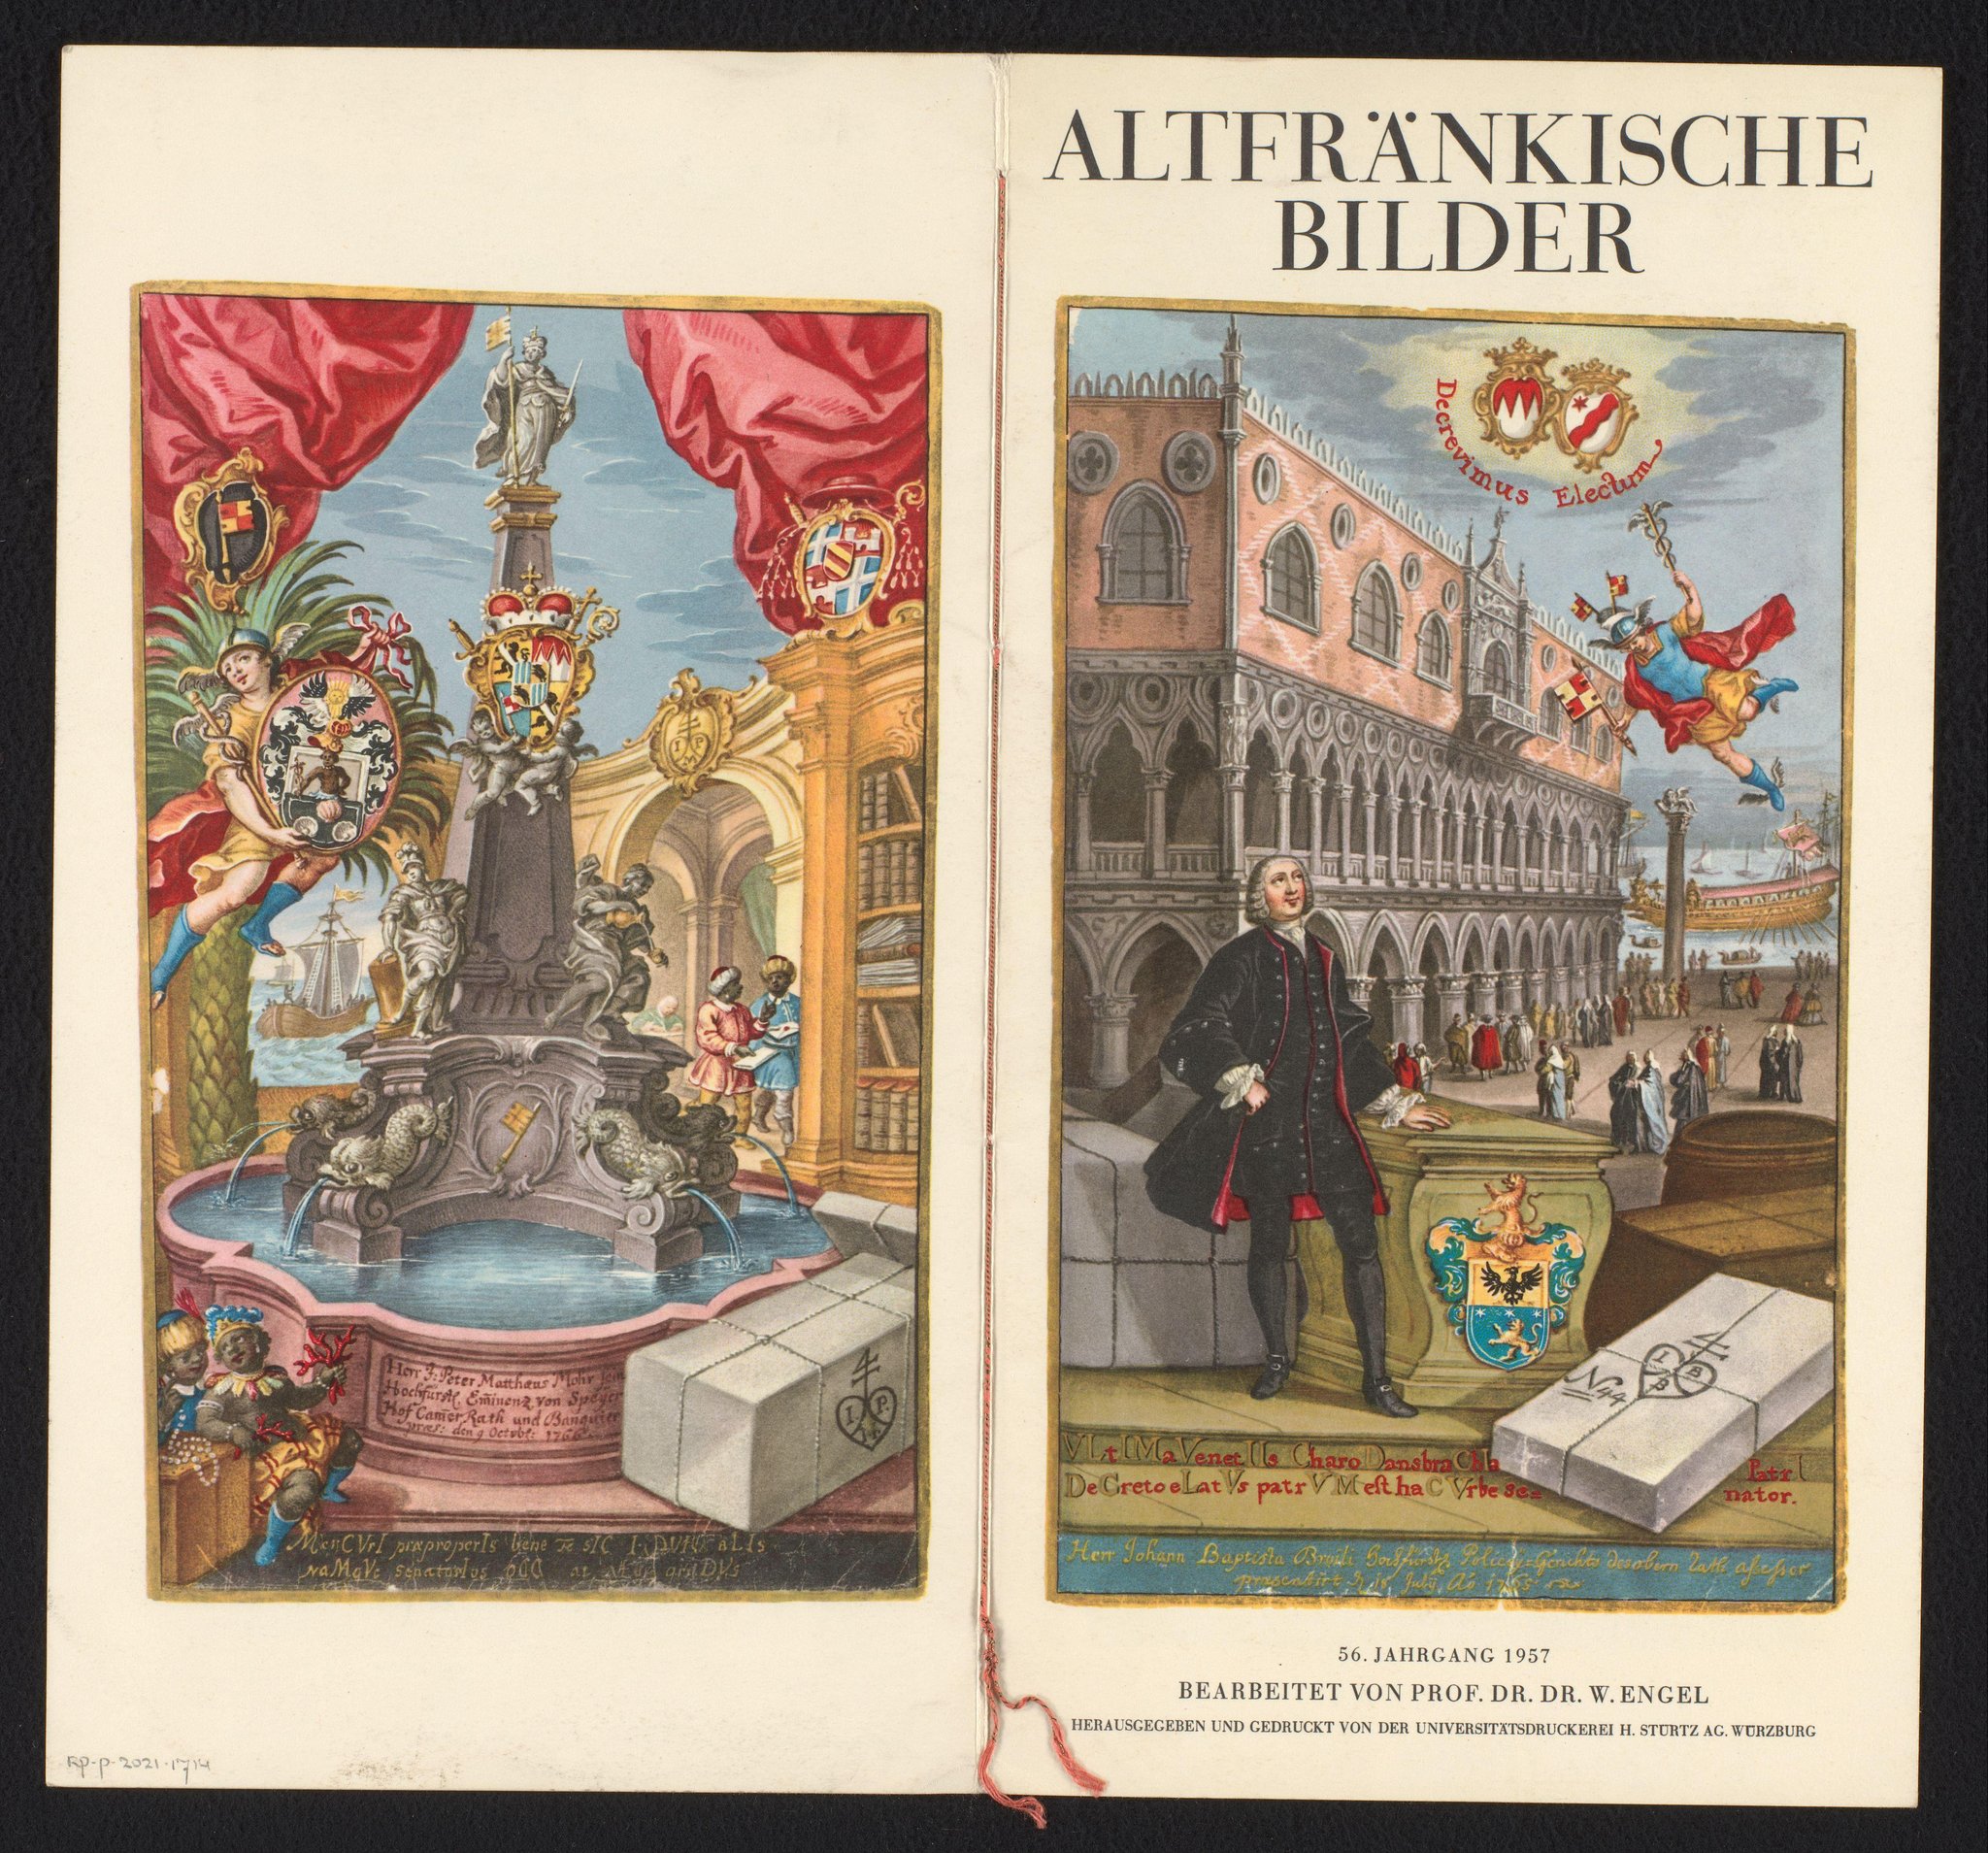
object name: photomechanical print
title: Altfränkische Bilder 56 (1957)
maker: Anonymous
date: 1957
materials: paper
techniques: bookbinding, lithograph, letterpress printing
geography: würzburg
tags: pamphlet ~ printed matter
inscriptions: date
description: Aflevering van een tijdschrift, zestien pagina's geïllustreerd met zwart-wit foto's en kleurenafbeeldingen op voor- en achterzijde van het omslag.